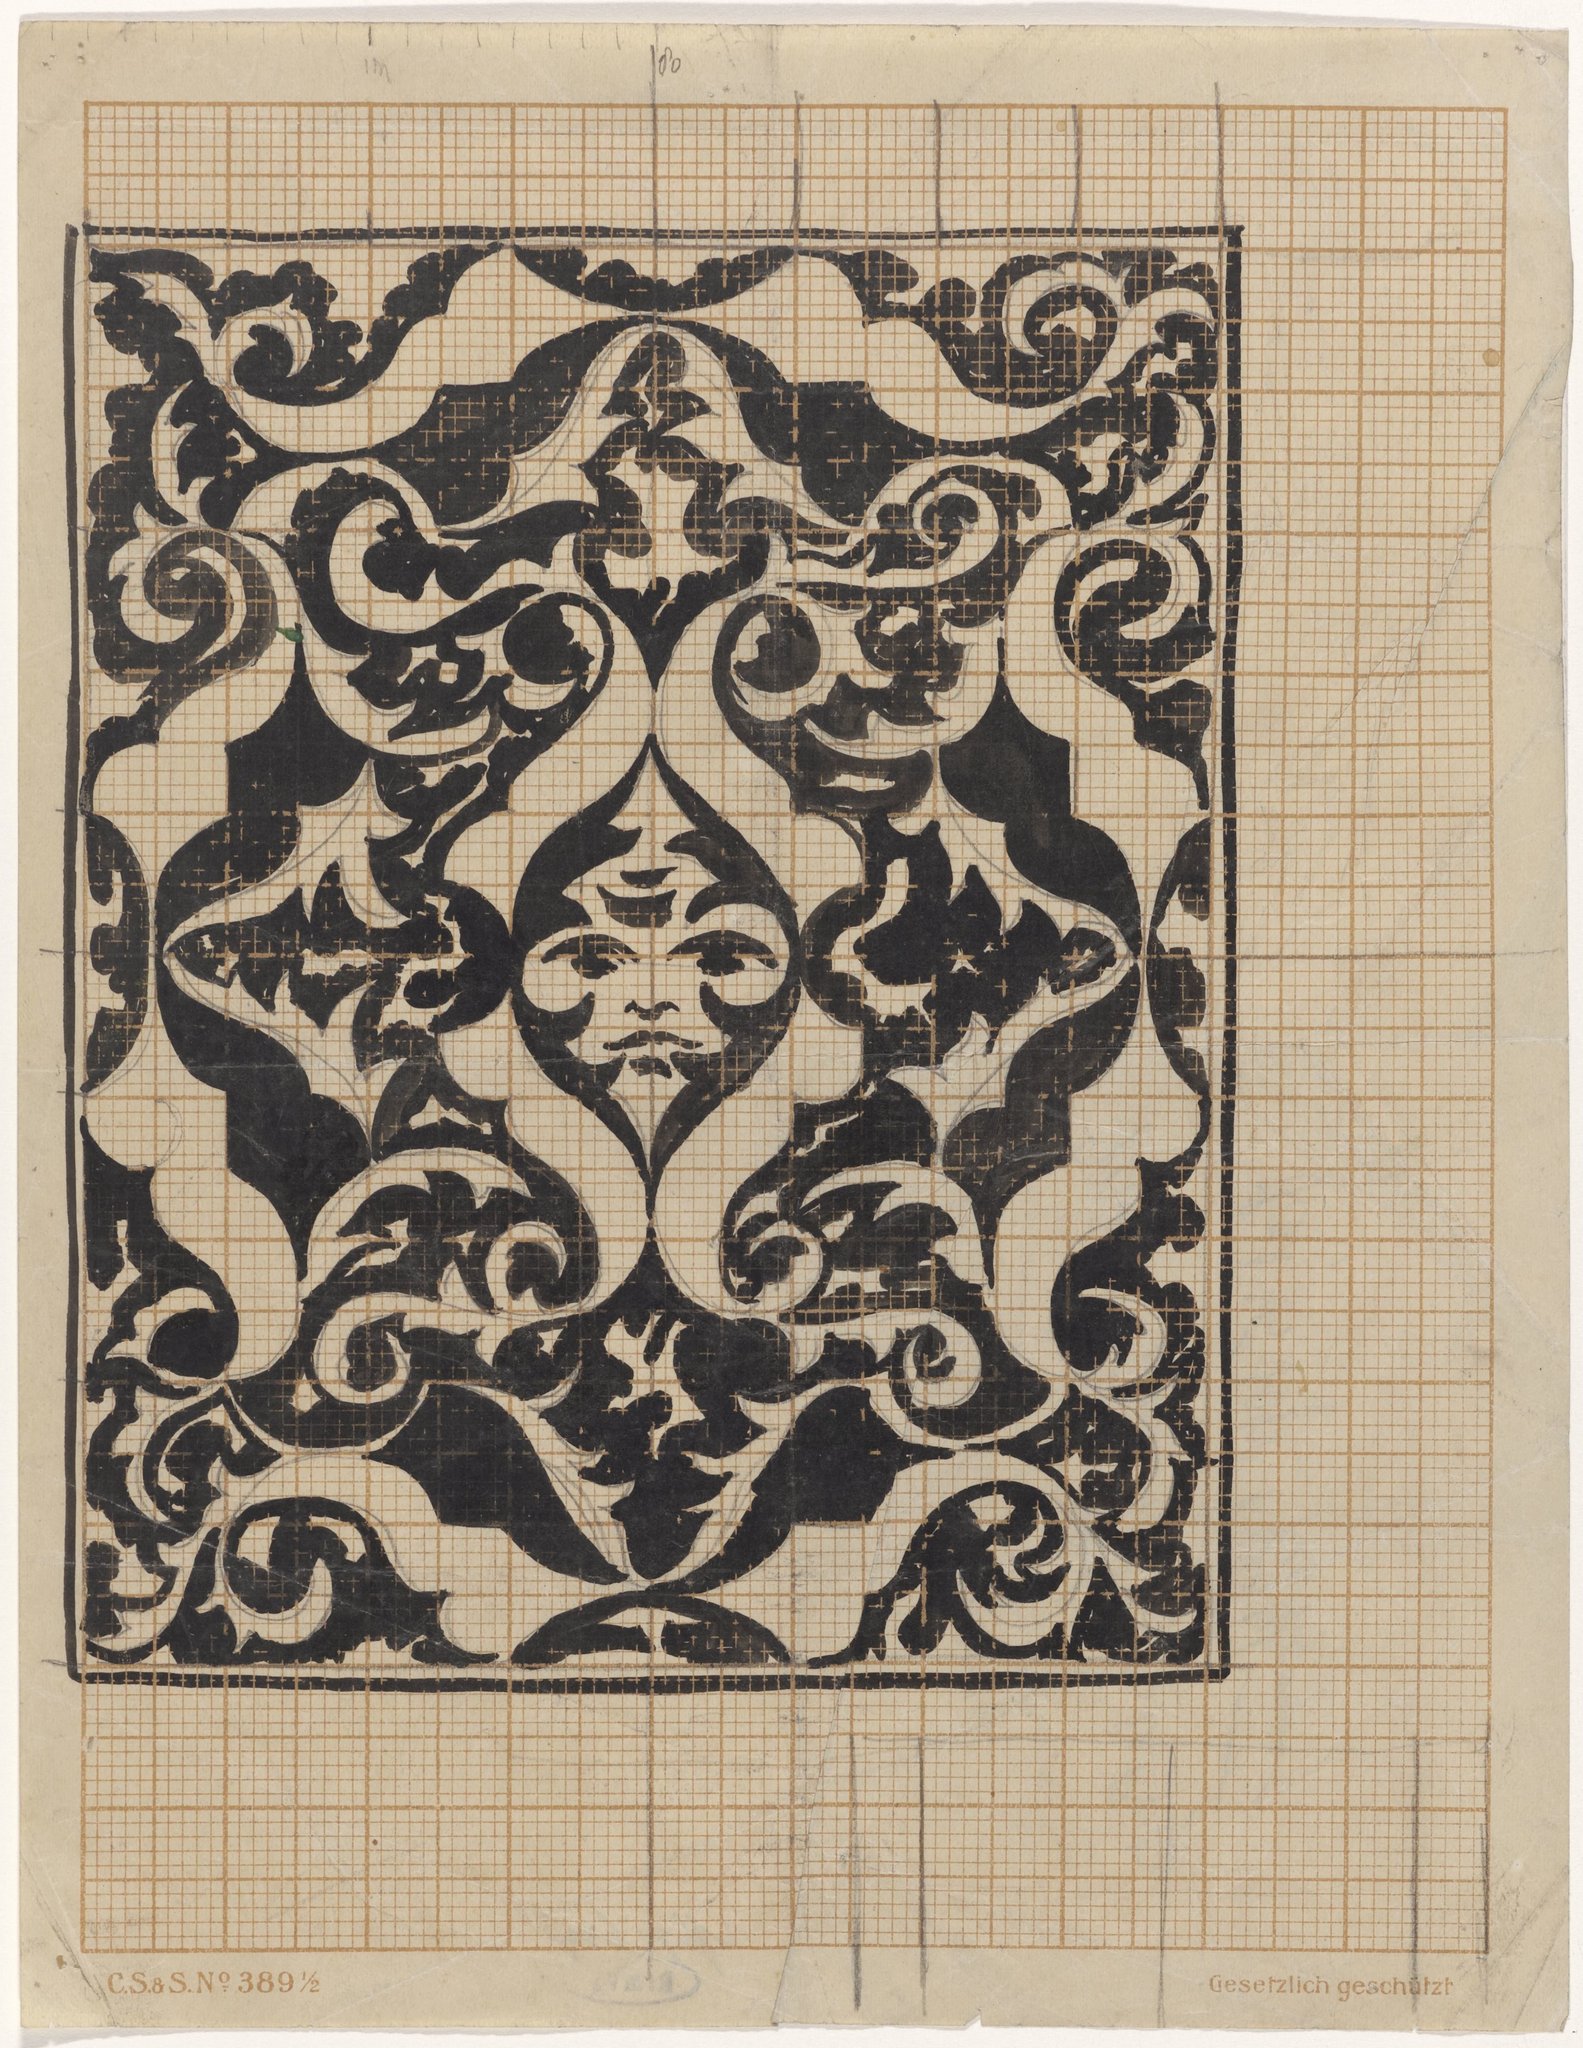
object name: drawing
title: Decoratief ontwerp met masker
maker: carel adolph lion cachet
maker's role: draughtsman, print maker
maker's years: 1864-1945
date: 1874-1945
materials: pencil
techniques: brush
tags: mask, mascaron ~ ornament